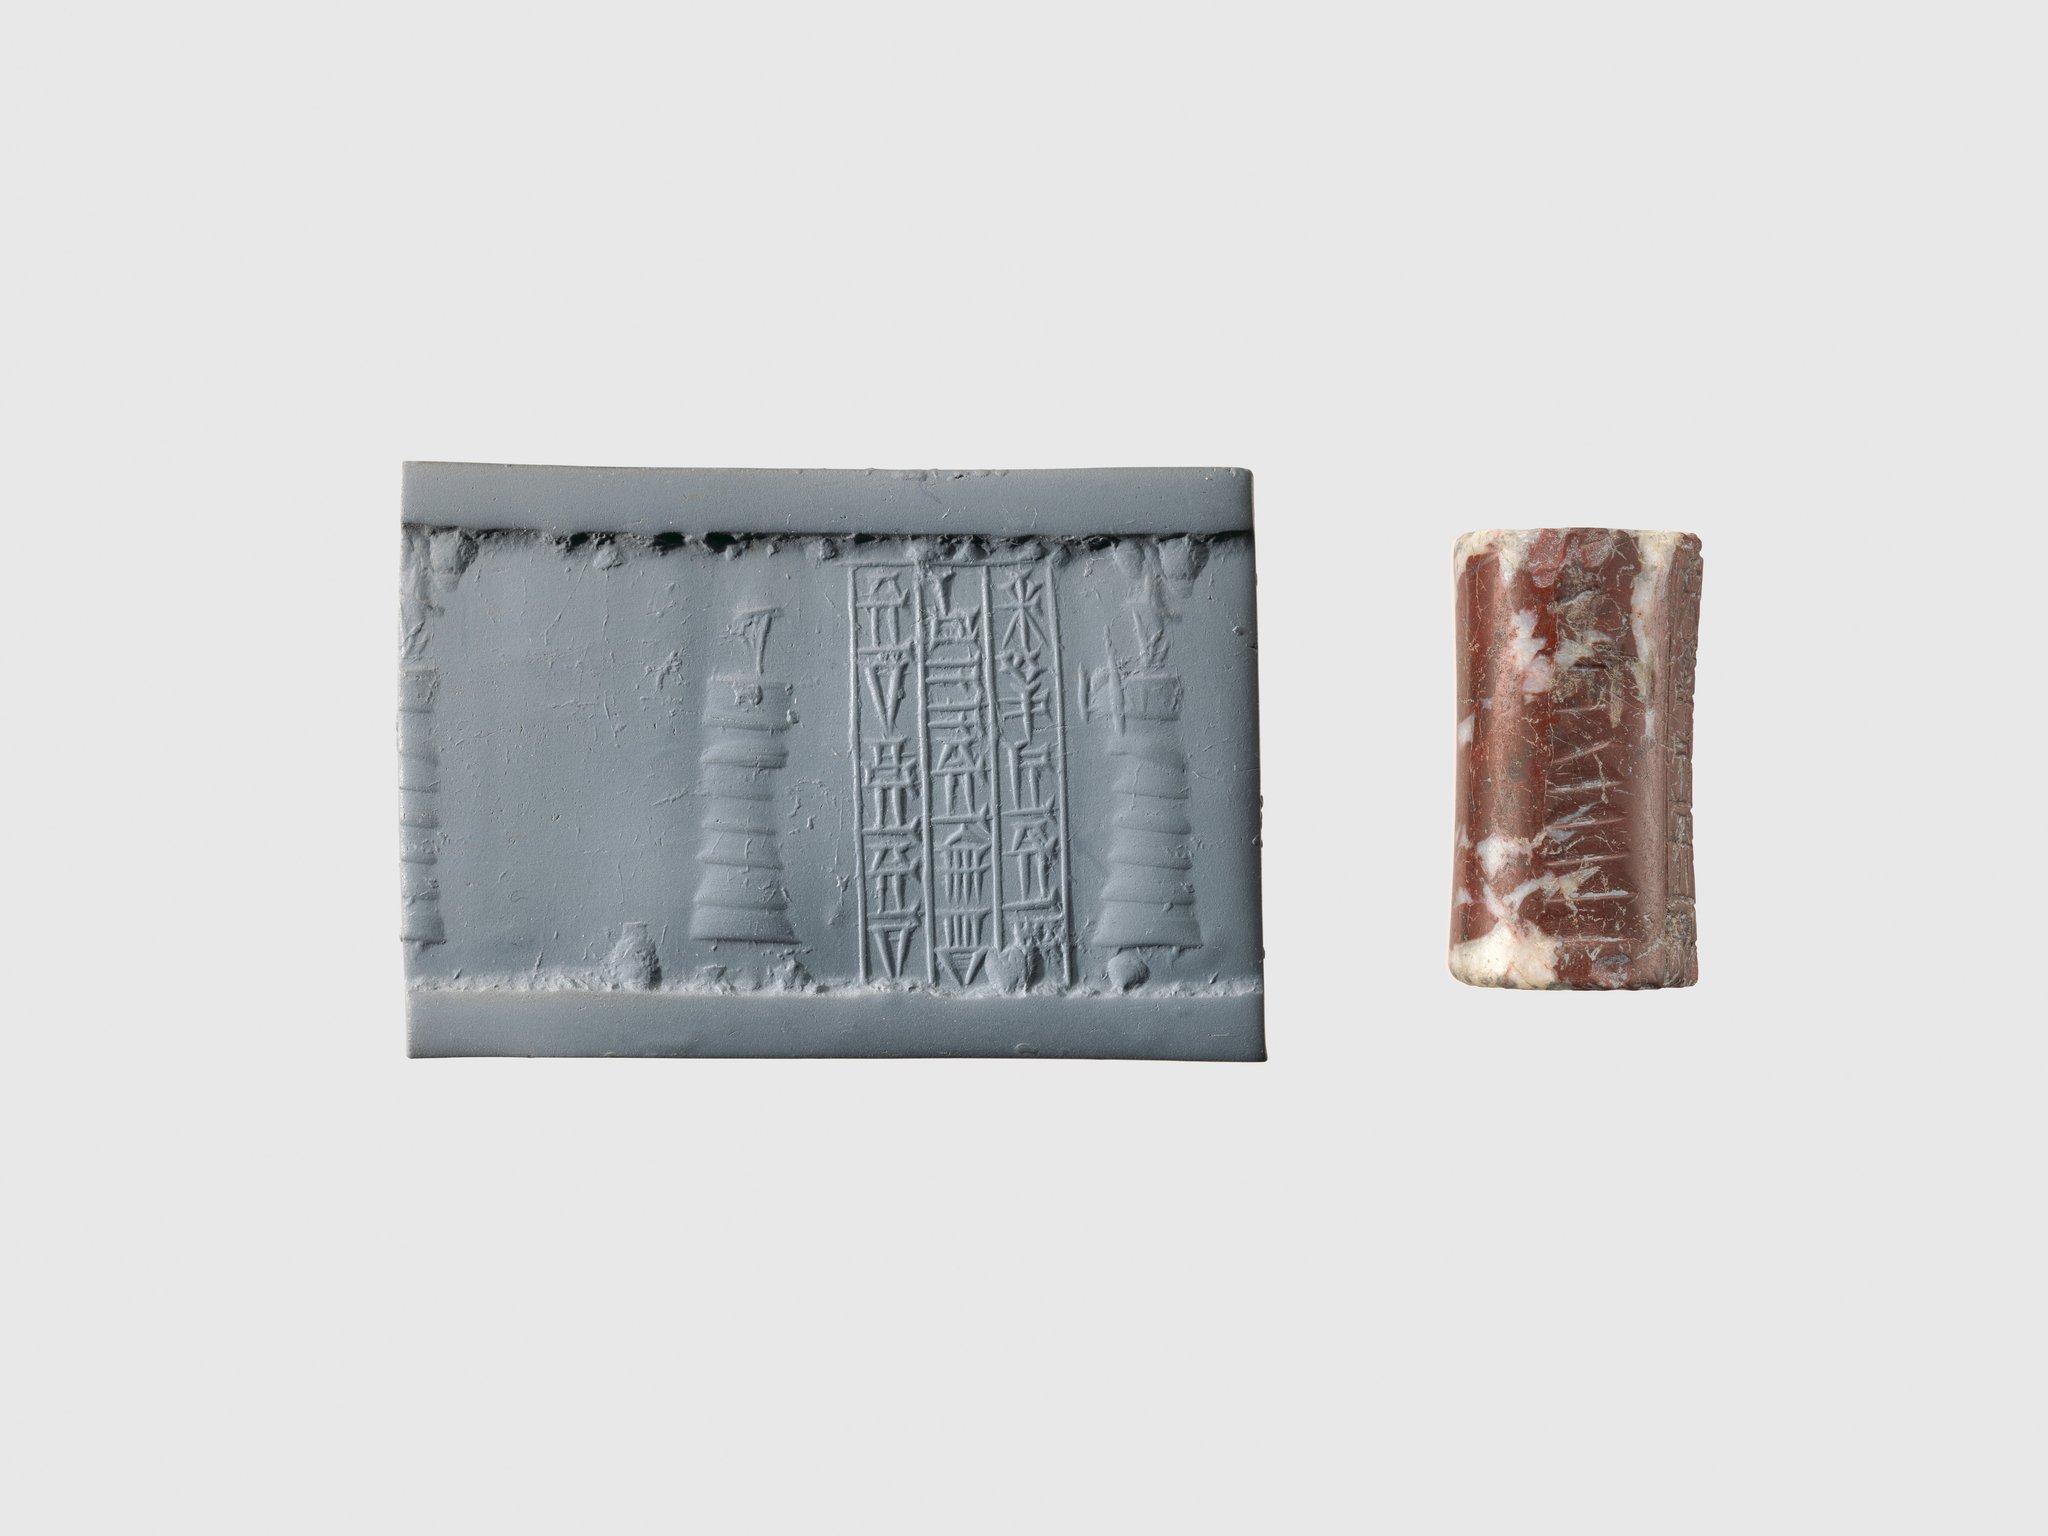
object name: cylinder seal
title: Cylinder seal and modern impression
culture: kassite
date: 1600-1101 BCE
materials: jasper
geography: mesopotamia